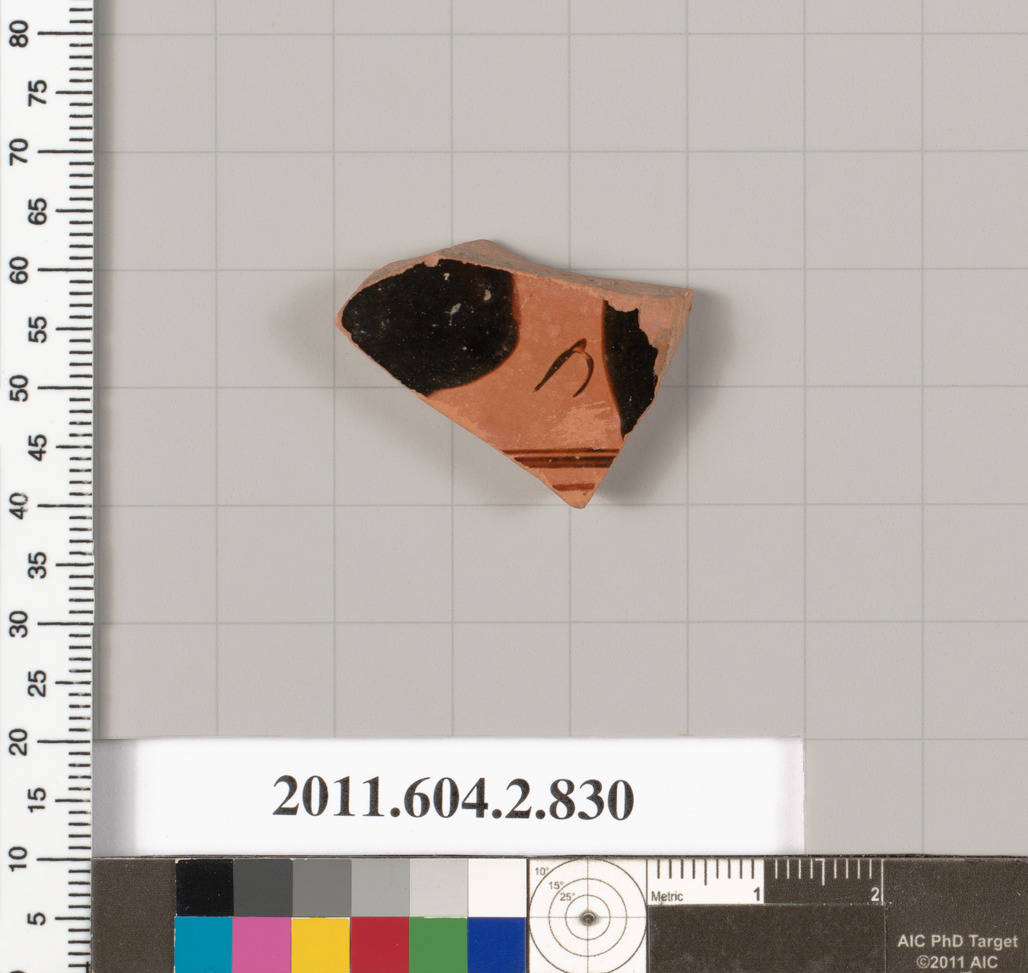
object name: bell krater fragment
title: Terracotta fragment of a bell-krater (bowl for mixing wine and water)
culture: greek, attic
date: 450-440 BCE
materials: terracotta